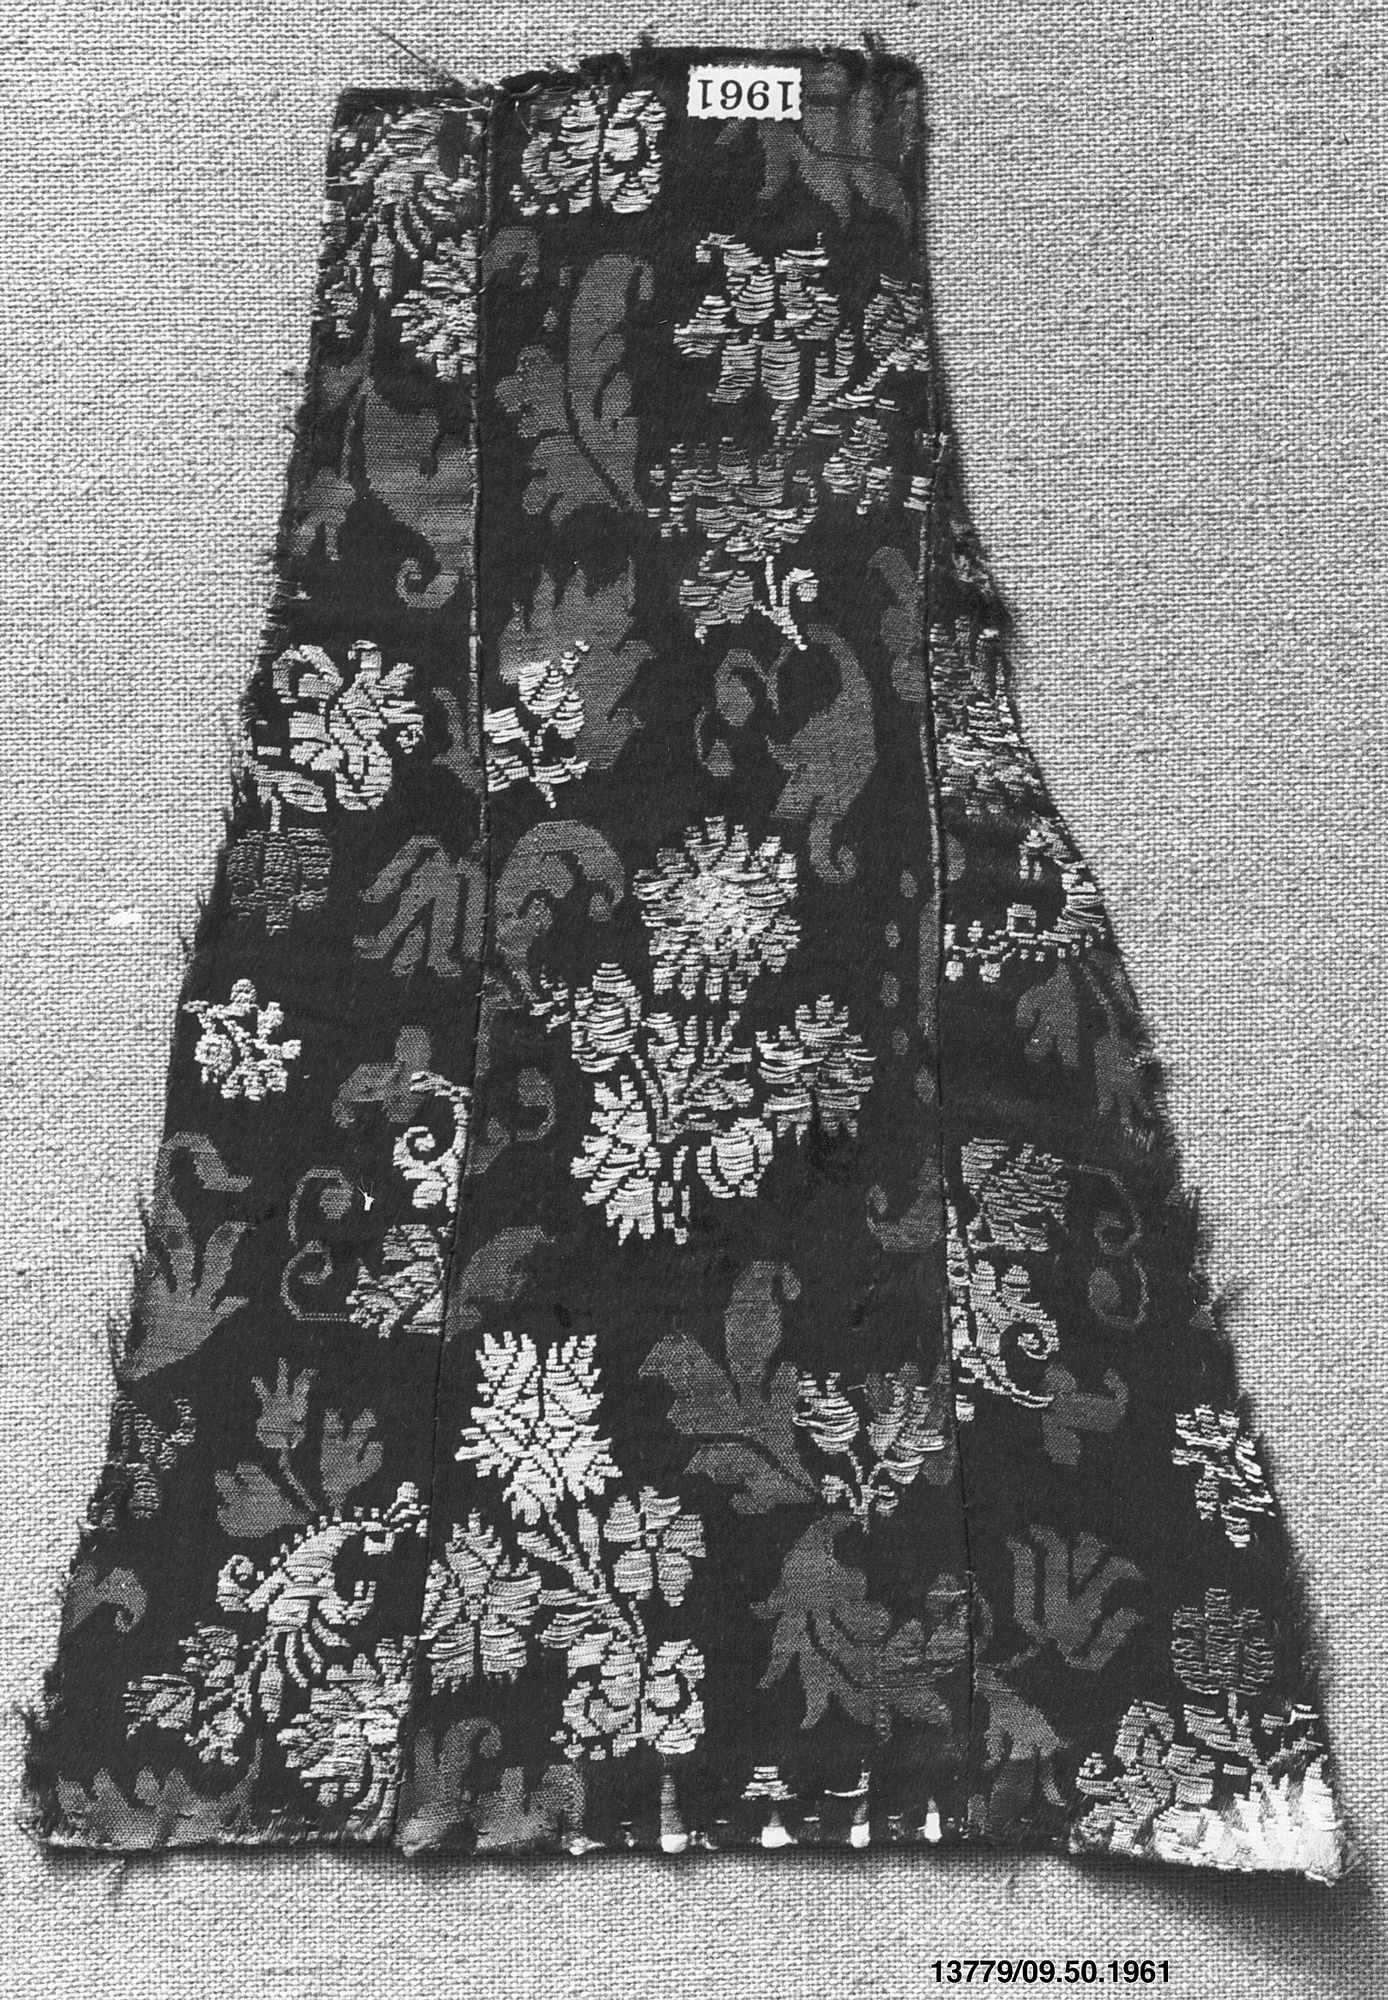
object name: piece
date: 1690-1695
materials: metal thread, silk